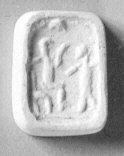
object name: stamp seal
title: Stamp seal (octagonal pyramid) with cultic scene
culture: assyrian or urartian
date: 900-601 BCE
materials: bronze, copper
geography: mesopotamia or syria